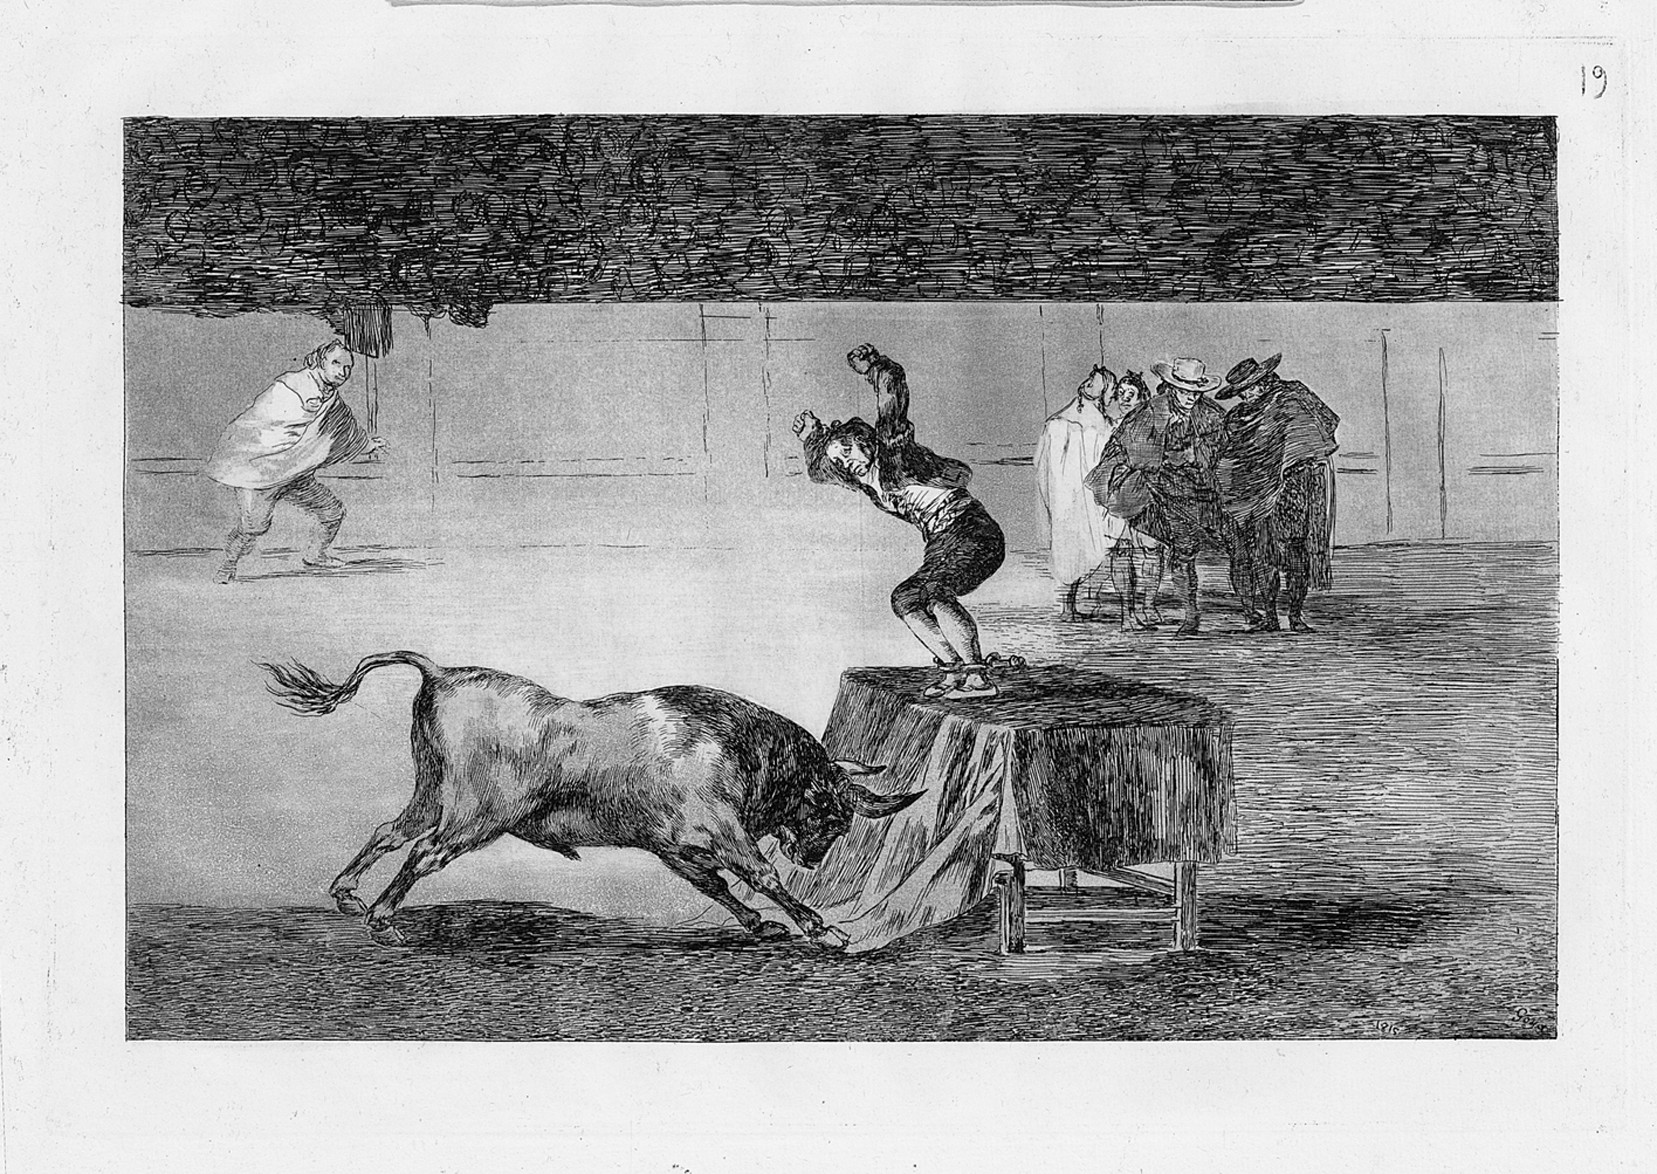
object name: print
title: The Bullfight, plates 1-33 (La Tauromaquia); First edition, 1816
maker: goya (francisco de goya y lucientes)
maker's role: artist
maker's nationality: spanish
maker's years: 1746-1828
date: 1816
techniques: aquatint, engraving, burnishing, drypoint, etching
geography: spain